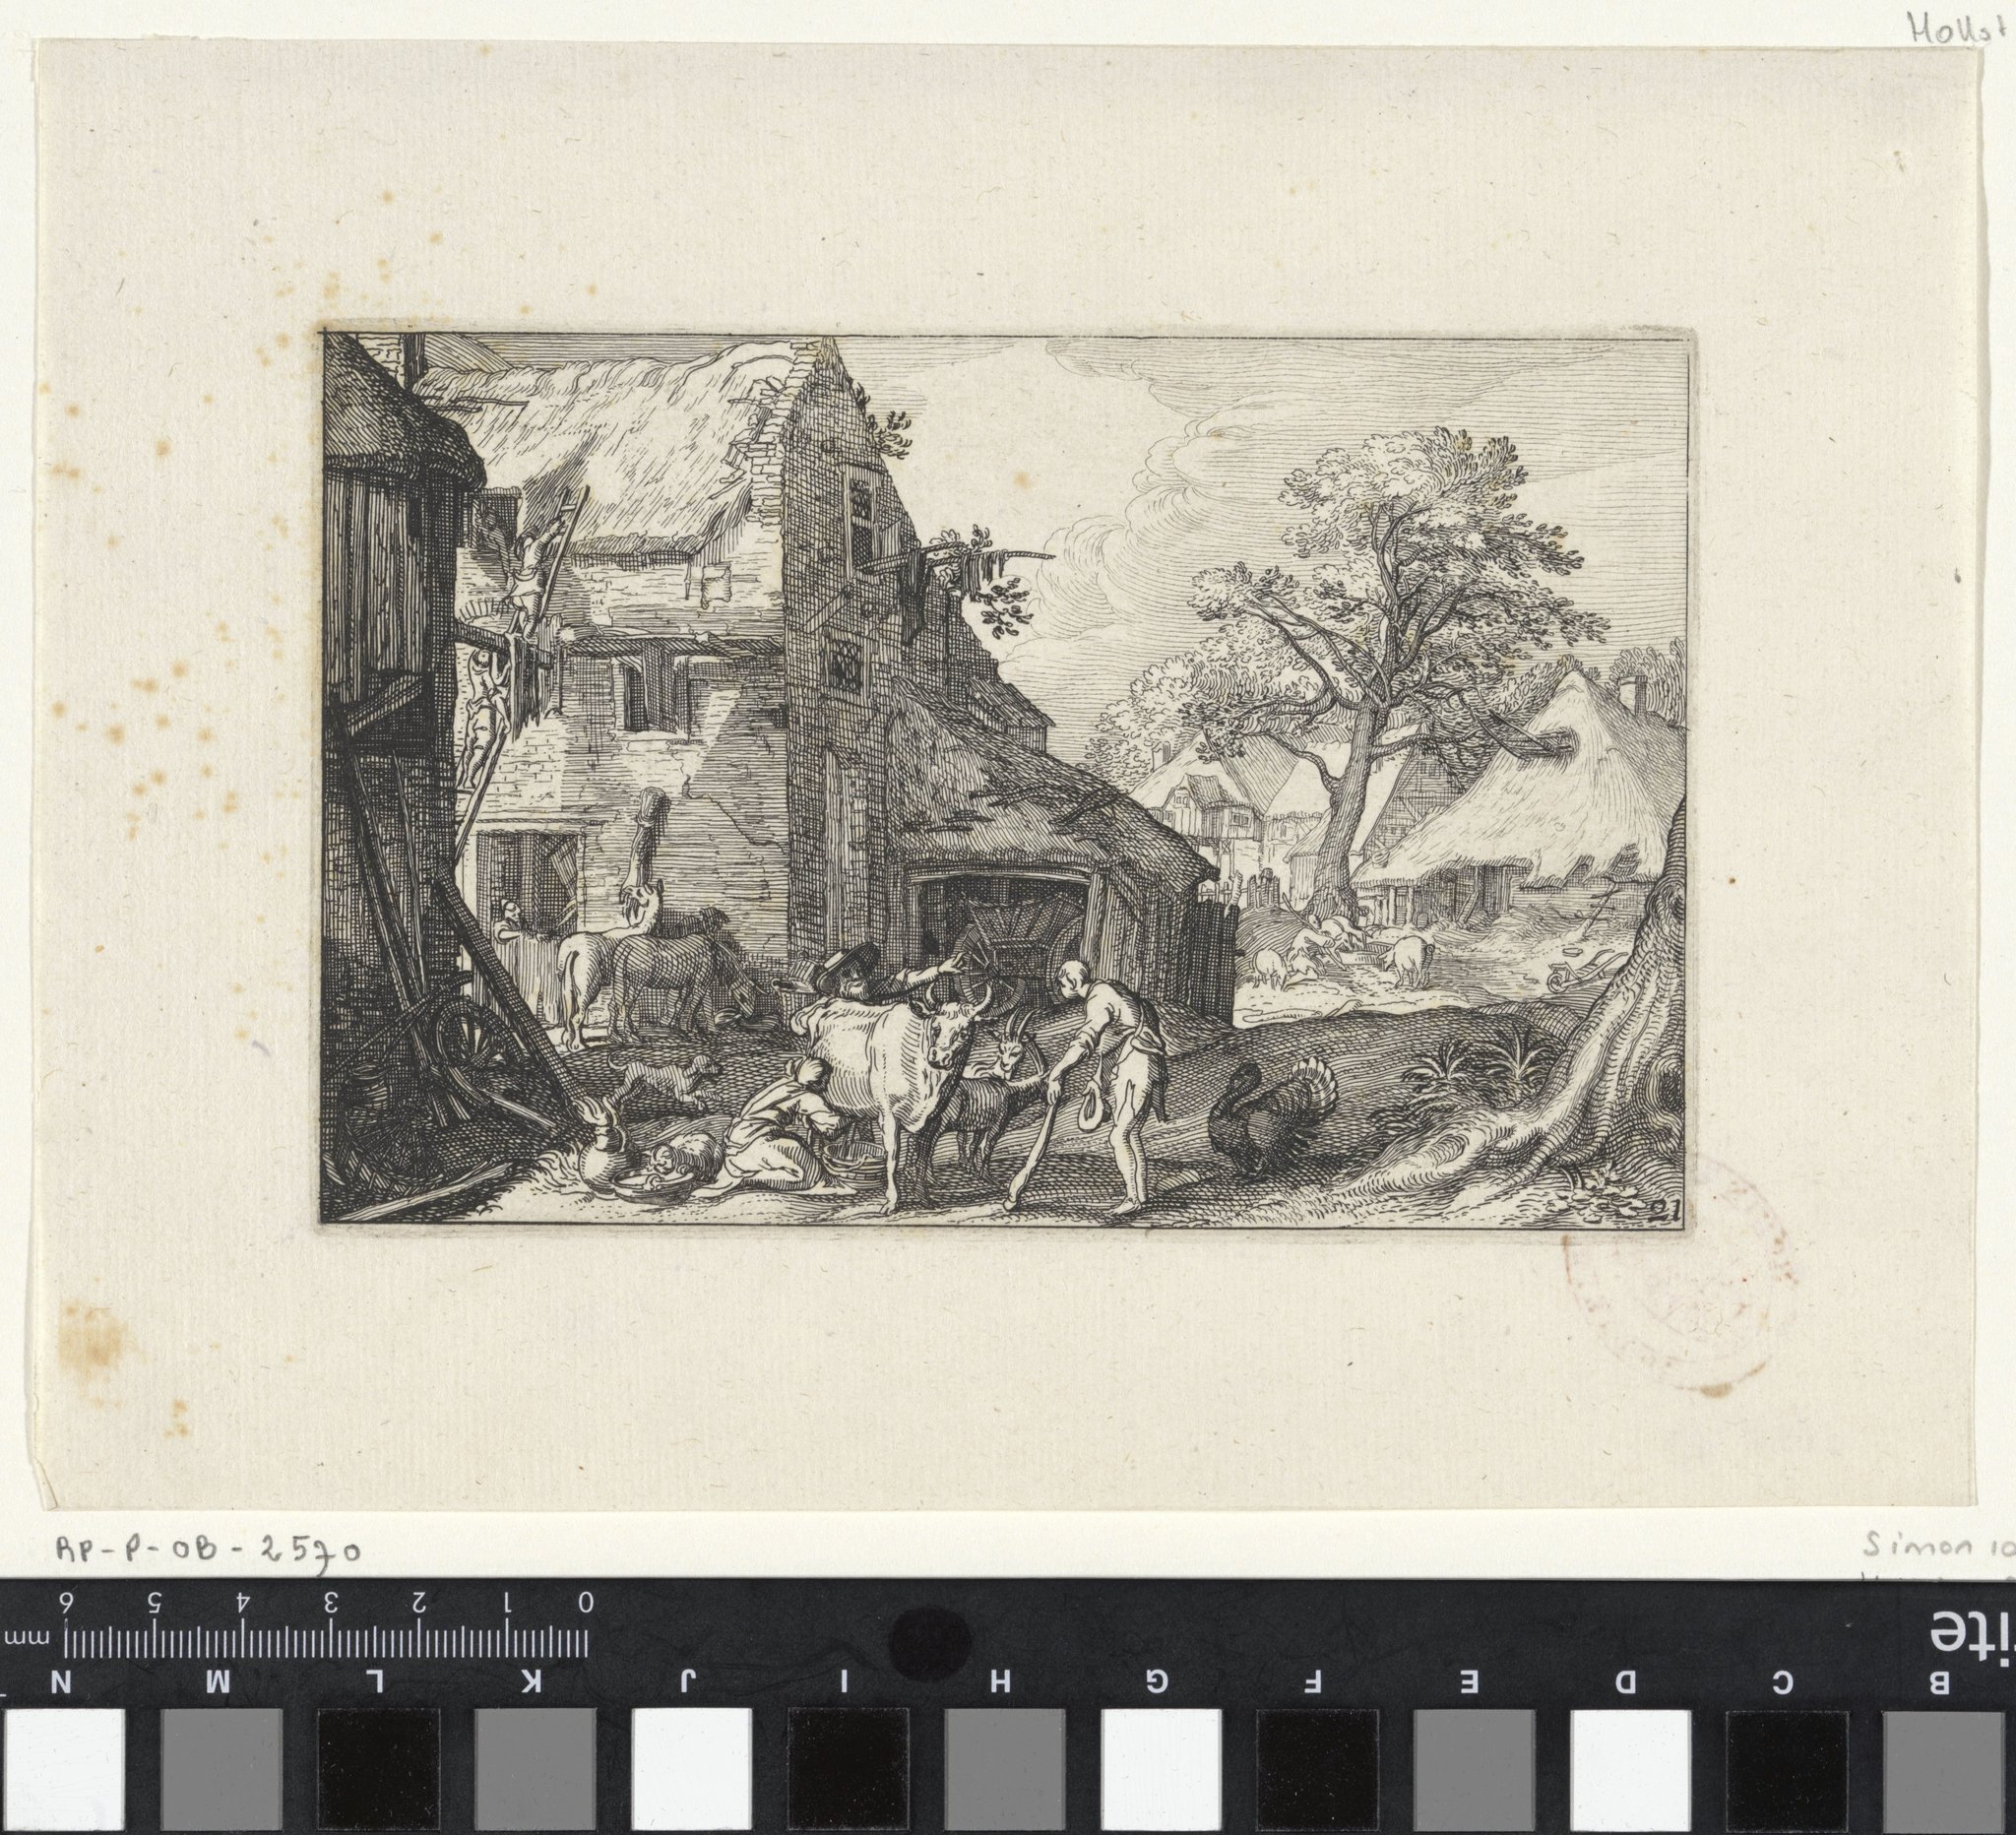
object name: print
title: Boerenerf met mensen en vee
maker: claes jansz. visscher (ii)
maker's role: draughtsman, print maker, publisher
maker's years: 1586-1652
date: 1620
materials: paper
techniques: etching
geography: amsterdam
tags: landscapes, farm or solitary house in landscape, farm (building), the prodigal son tends the swine and eats from their trough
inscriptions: collector's mark: Lugt 240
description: Boerenerf met op de voorgrond een vrouw die een koe melkt en twee mannen die een gesprek voeren. Rechts op de achtergrond een jonge man tussen de zwijnen, mogelijk de verloren zoon.